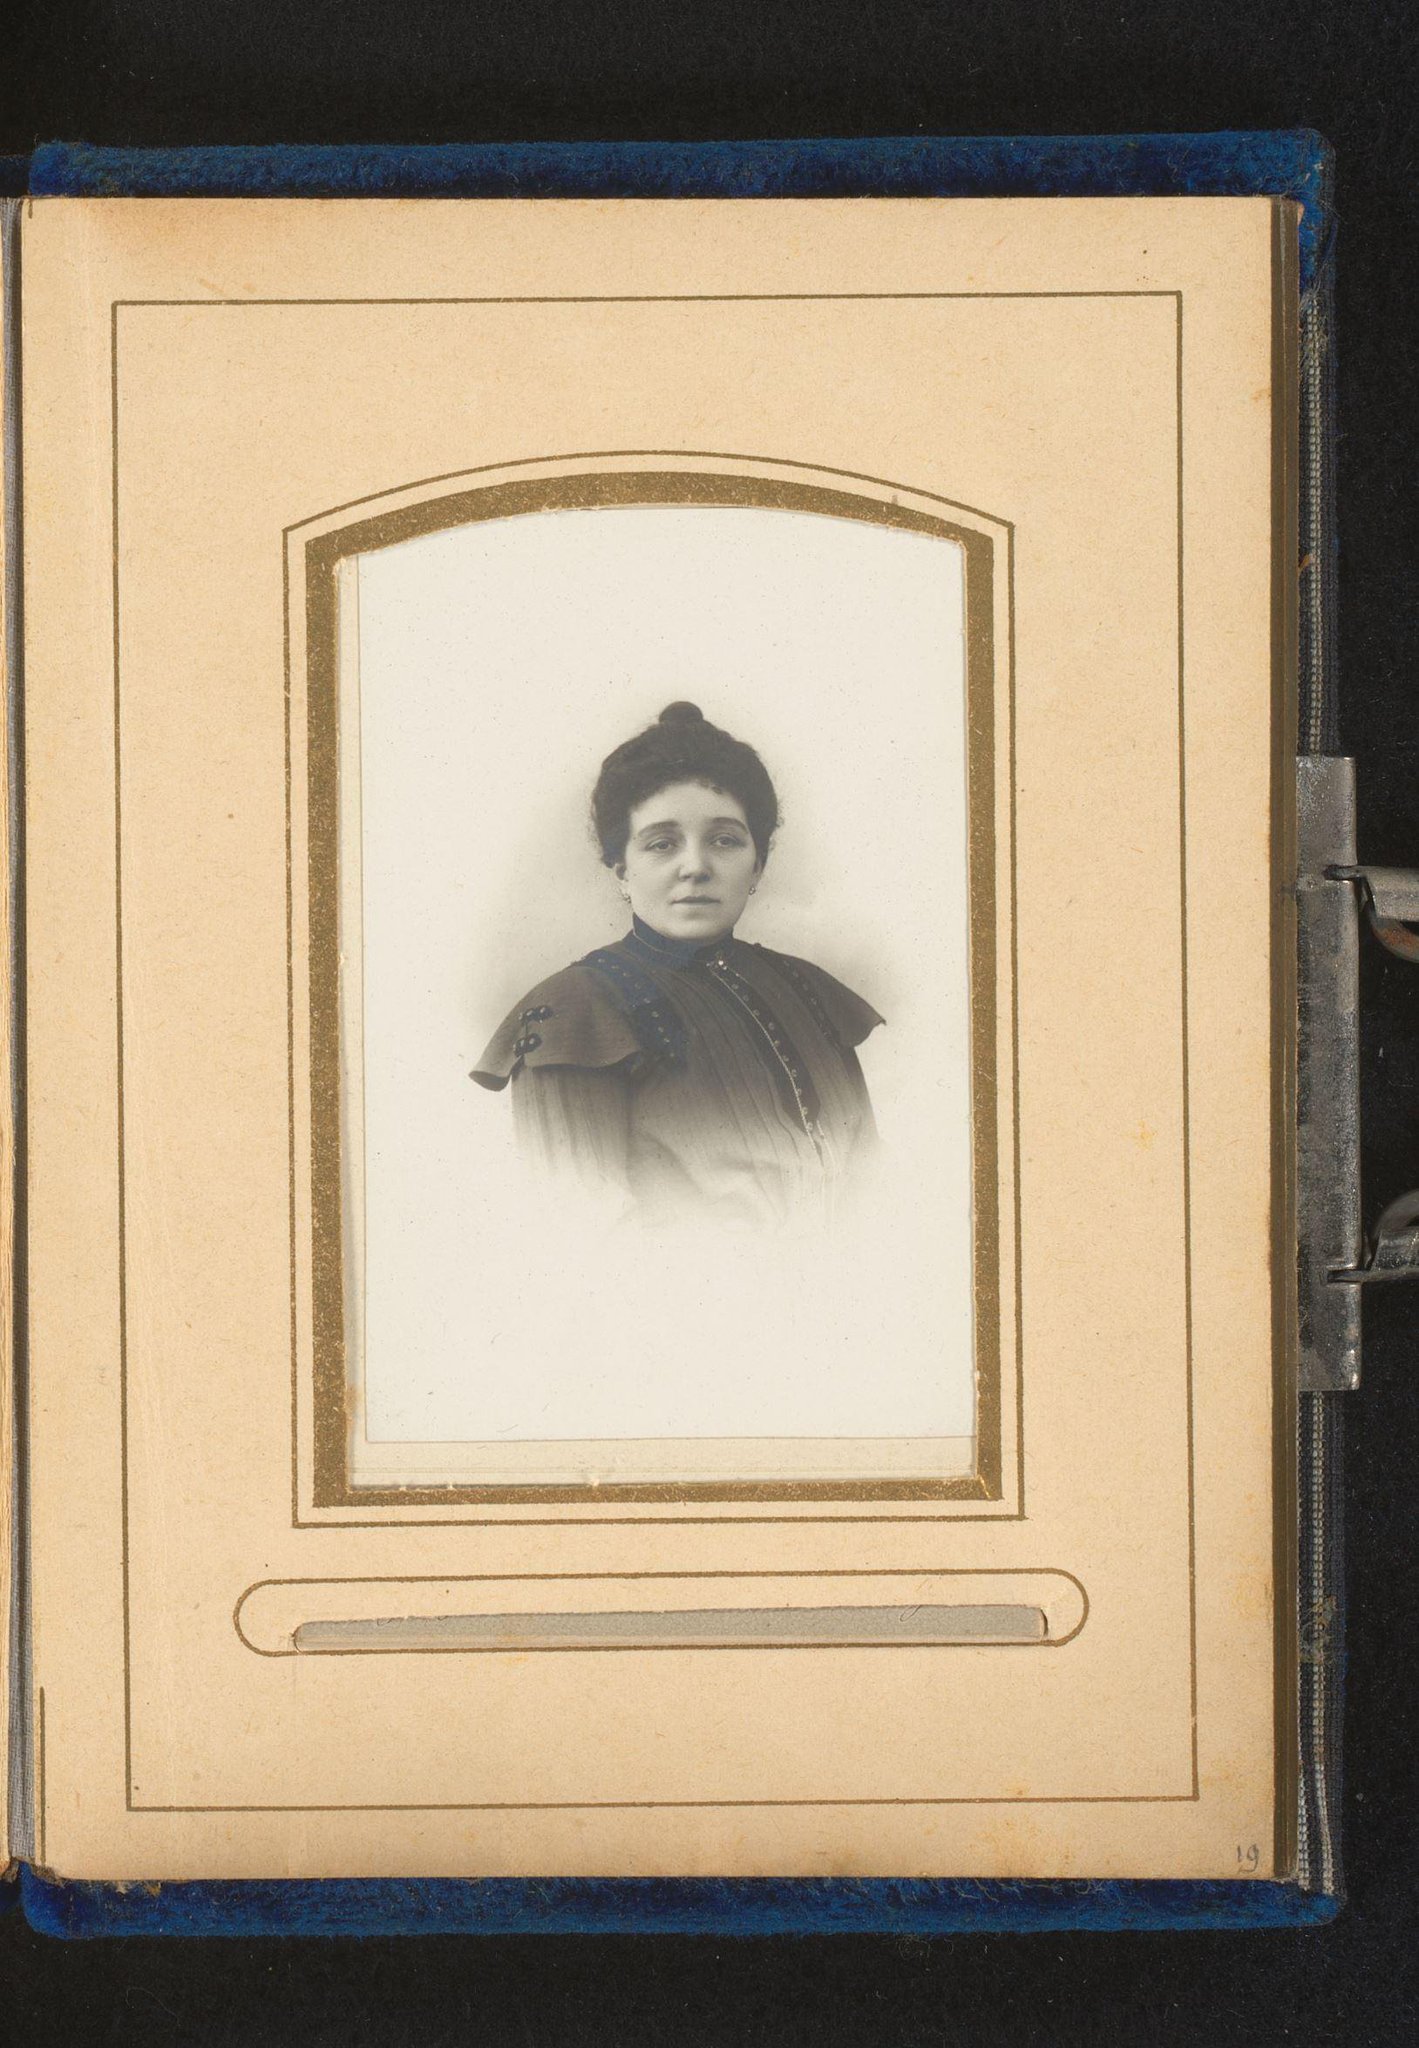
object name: photograph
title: Portret van een vrouw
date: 1915-1930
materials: cardboard, photographic support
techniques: gelatin silver print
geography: lyon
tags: historical persons - bb - woman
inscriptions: inscription: ‘PHOTOGRAPHIE/ TÉLÉPHONE/ Reynaud et P Giron/ 6/ Rue de la République/ LYON/ Photographie de Nuit/ à la/ Lumière artificielle/ Les Clichés sont conservés’